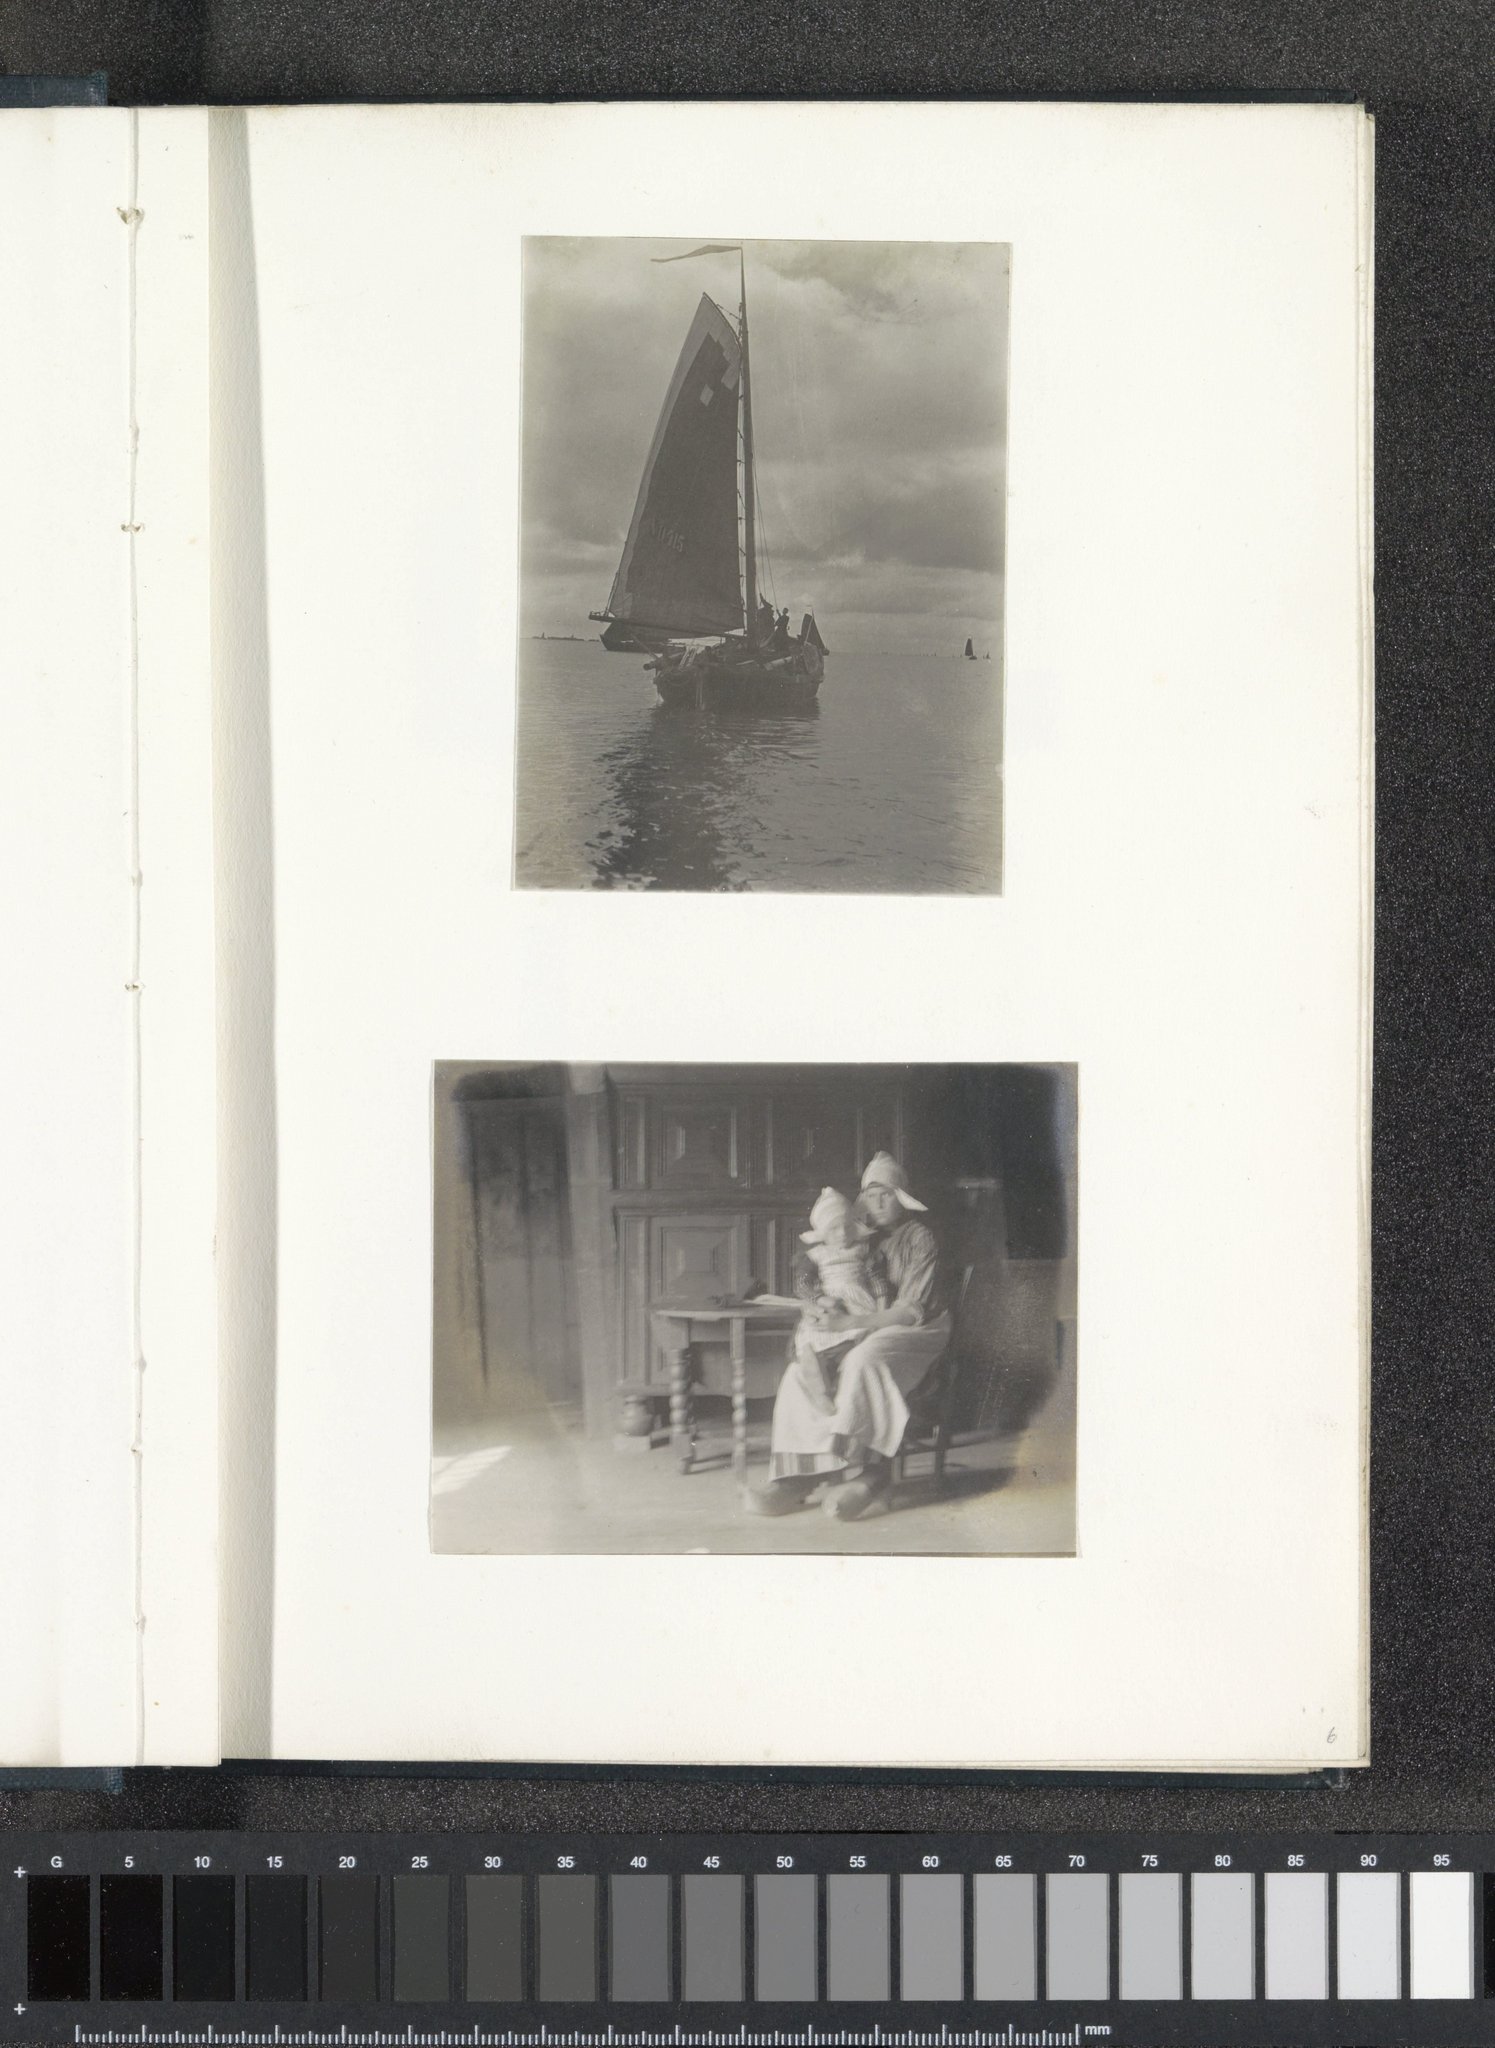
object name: photograph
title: Volendams vissersschip op de Zuiderzee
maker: george hidderley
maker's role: fotograaf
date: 1900-1910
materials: paper, photographic support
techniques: gelatin silver print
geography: zuiderzee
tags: sailing-ship, sailing-boat, sea, zuiderzee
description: Onderdeel van fotoalbum met opnames van Volendam, Dordrecht, Gorinchem en Woudrichem.